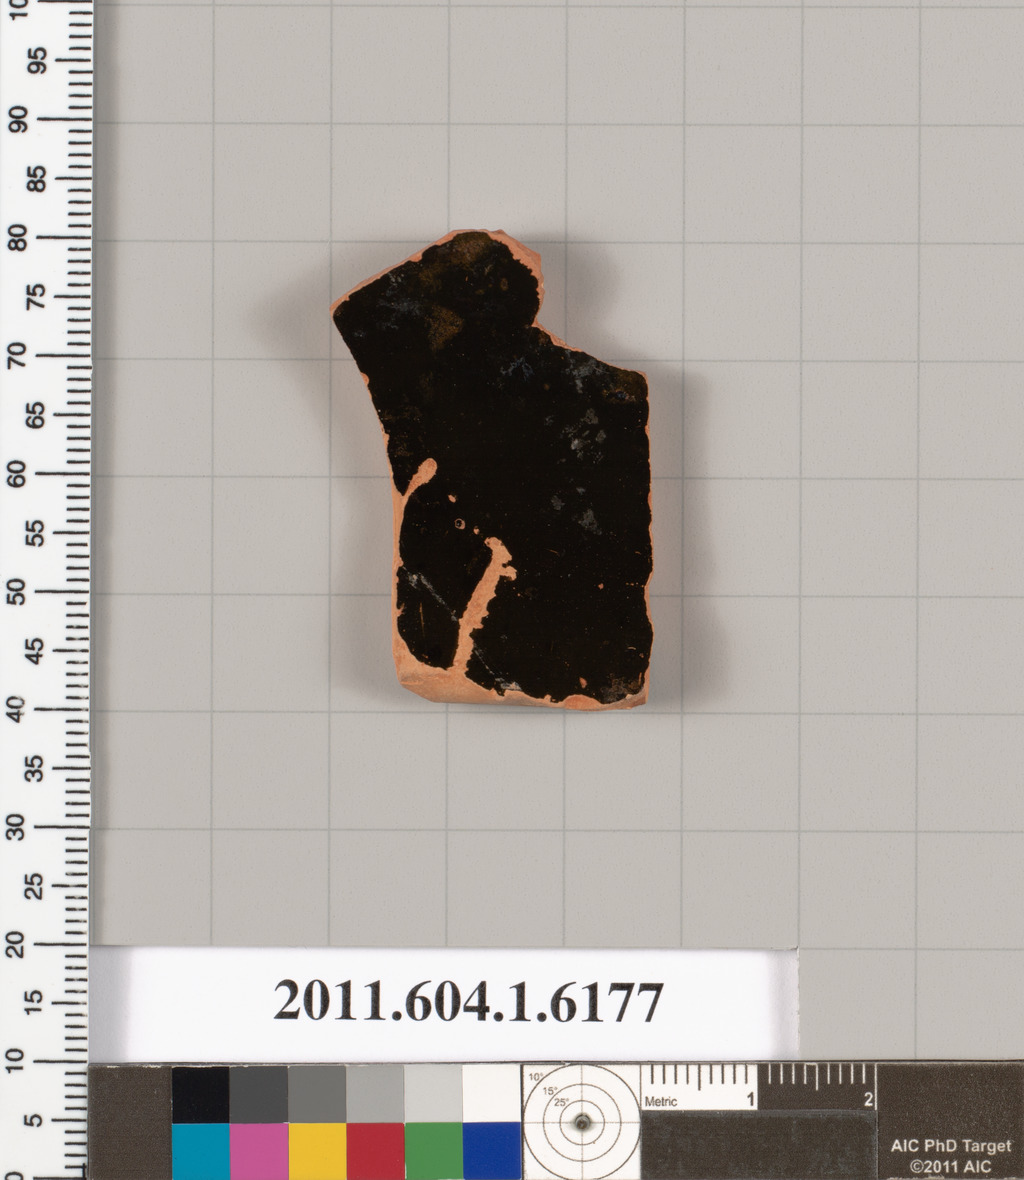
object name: kylix fragment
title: Terracotta fragment of a kylix (drinking cup)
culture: greek, attic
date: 520-500 BCE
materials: terracotta